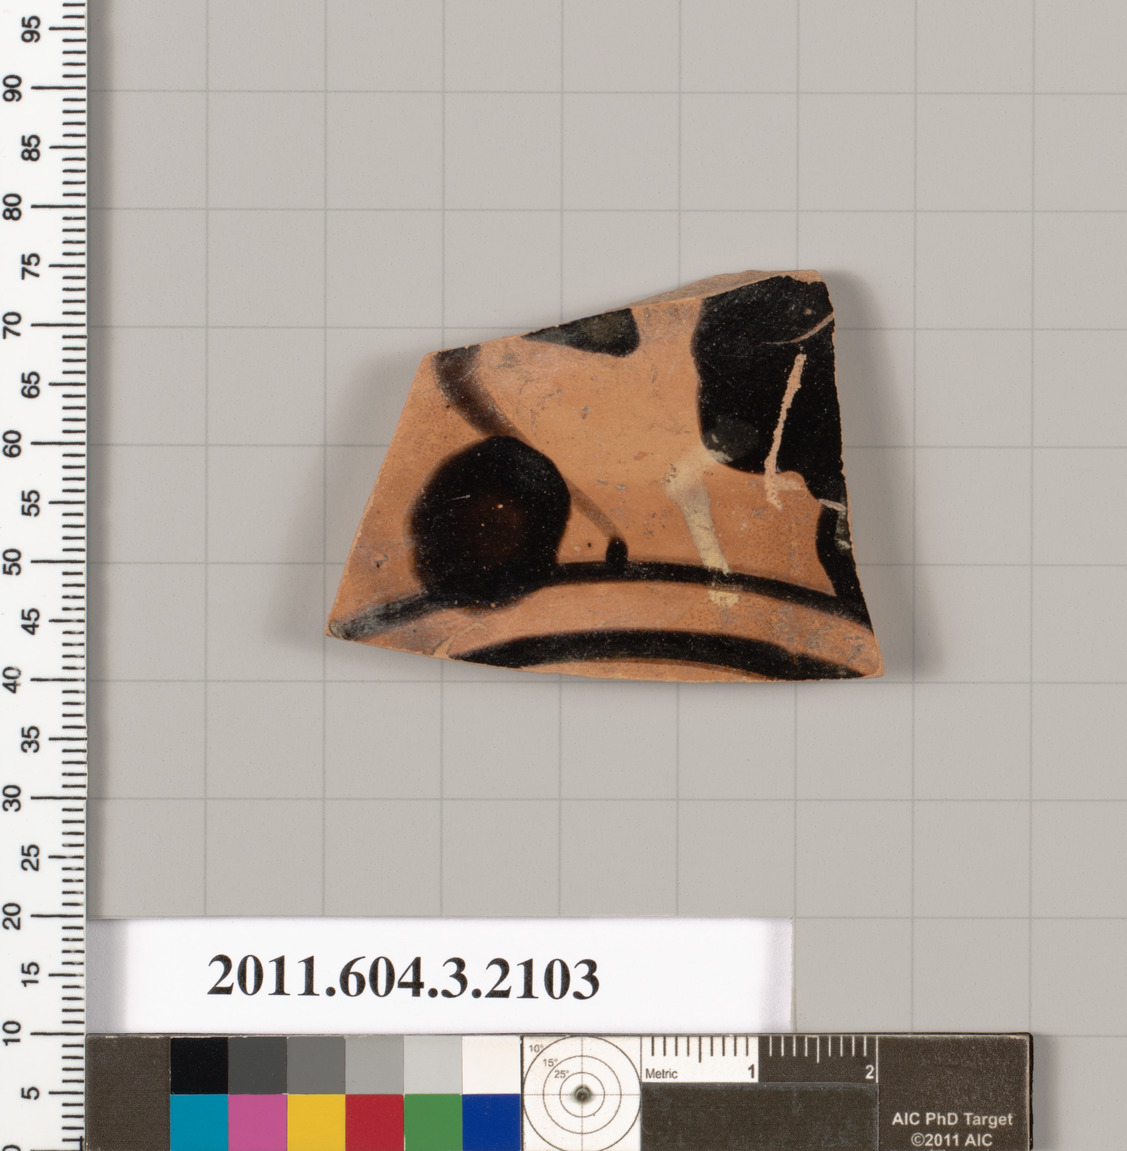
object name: kylix fragment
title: Terracotta fragment of a kylix (drinking cup)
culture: greek, attic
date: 534-468 BCE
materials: terracotta